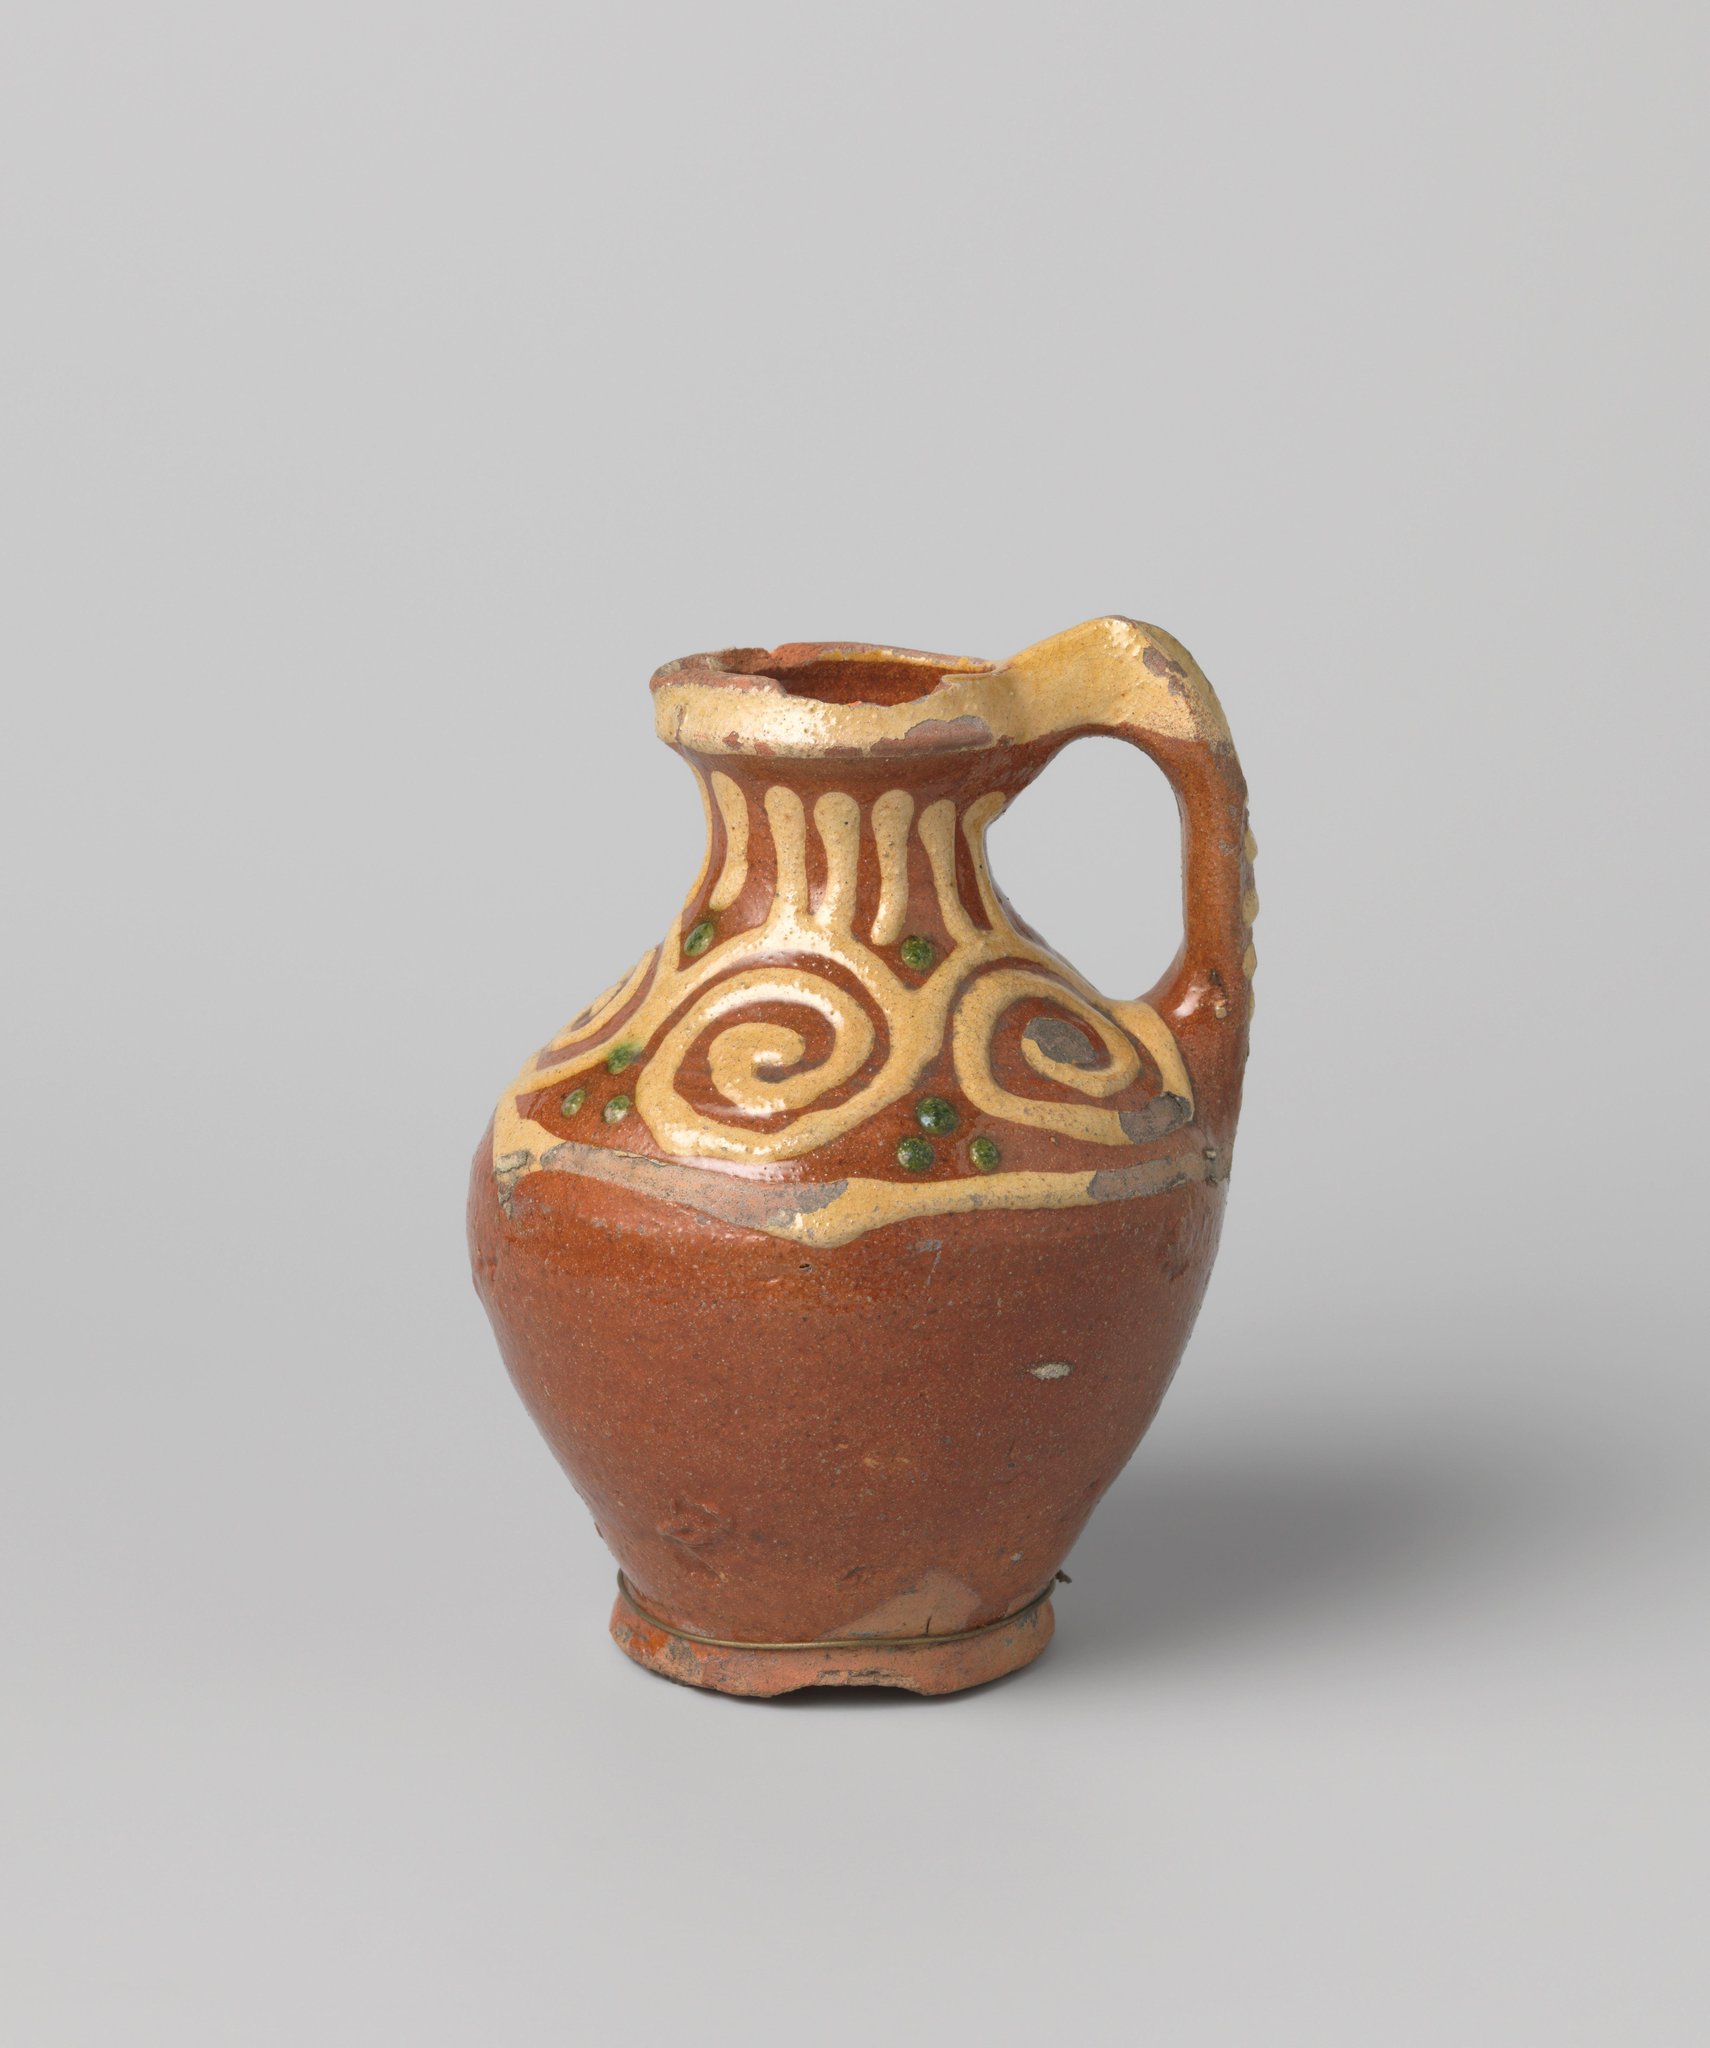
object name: ewer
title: Kan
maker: Anonymous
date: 1625-1675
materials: earthenware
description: Bolvormige kan van steengoed. De kan heeft een oor en een korte, ingesnoerde hals. De hals en de schouder zijn gedecoreerd met gele slib; op de hals verticale lijnen en op de schouder spiralen.